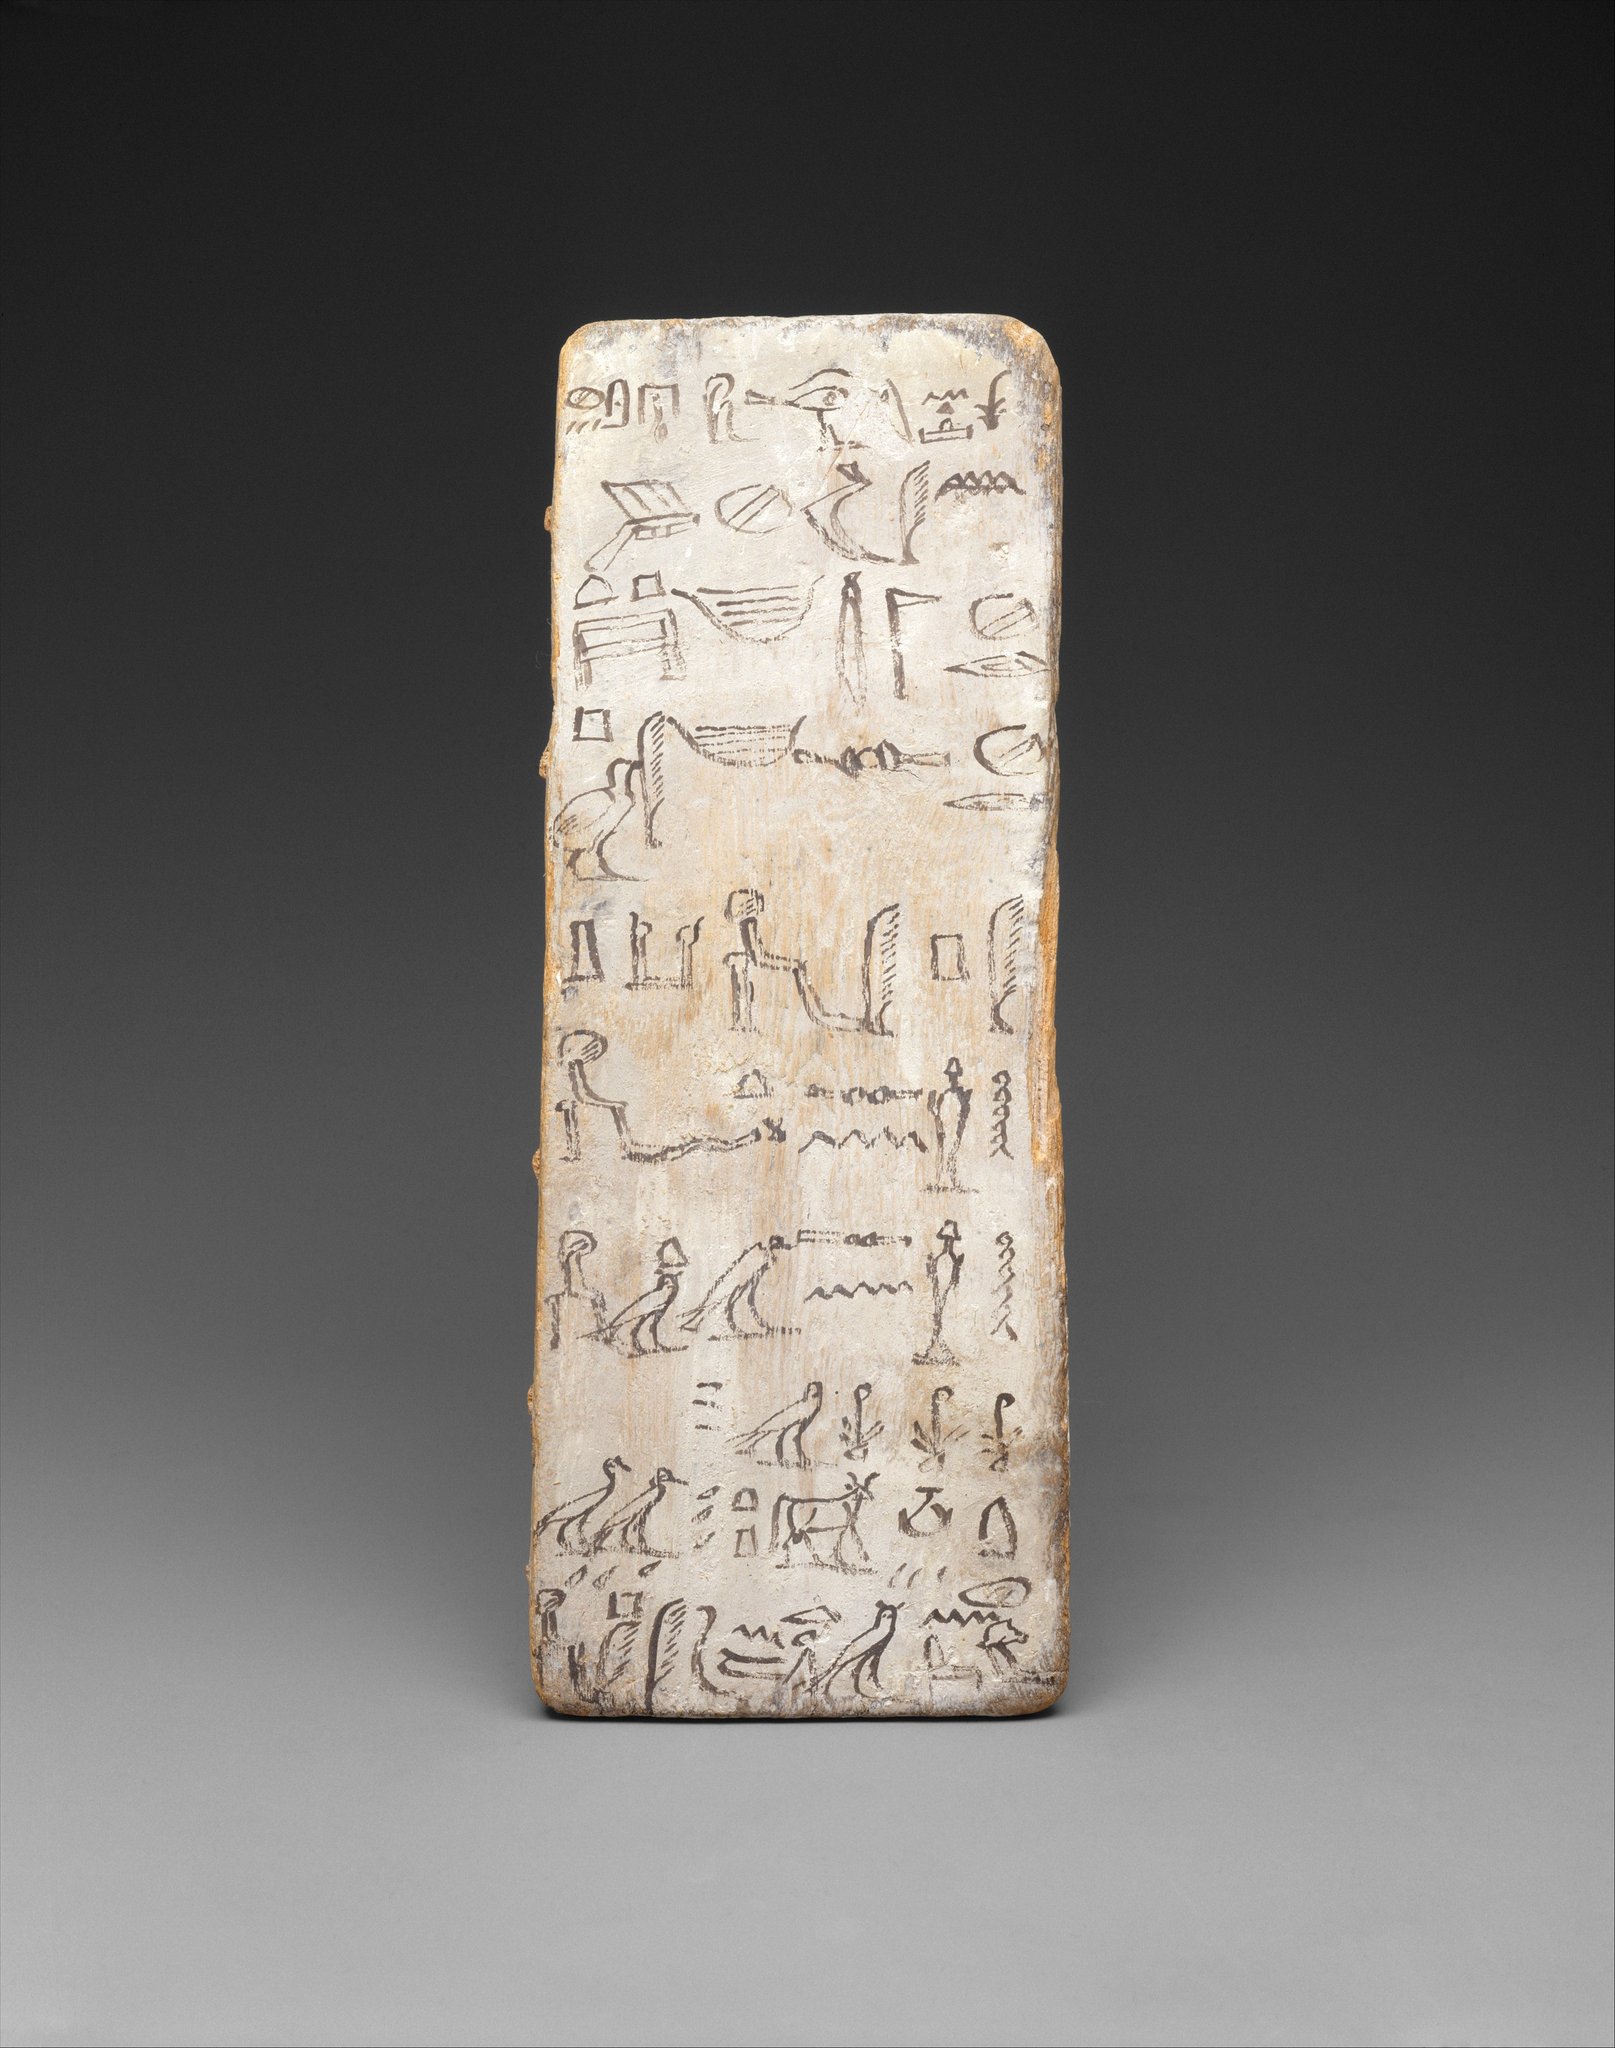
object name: writing board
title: Writing board of an apprentice scribe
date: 2030 BCE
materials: ink, wood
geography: egypt